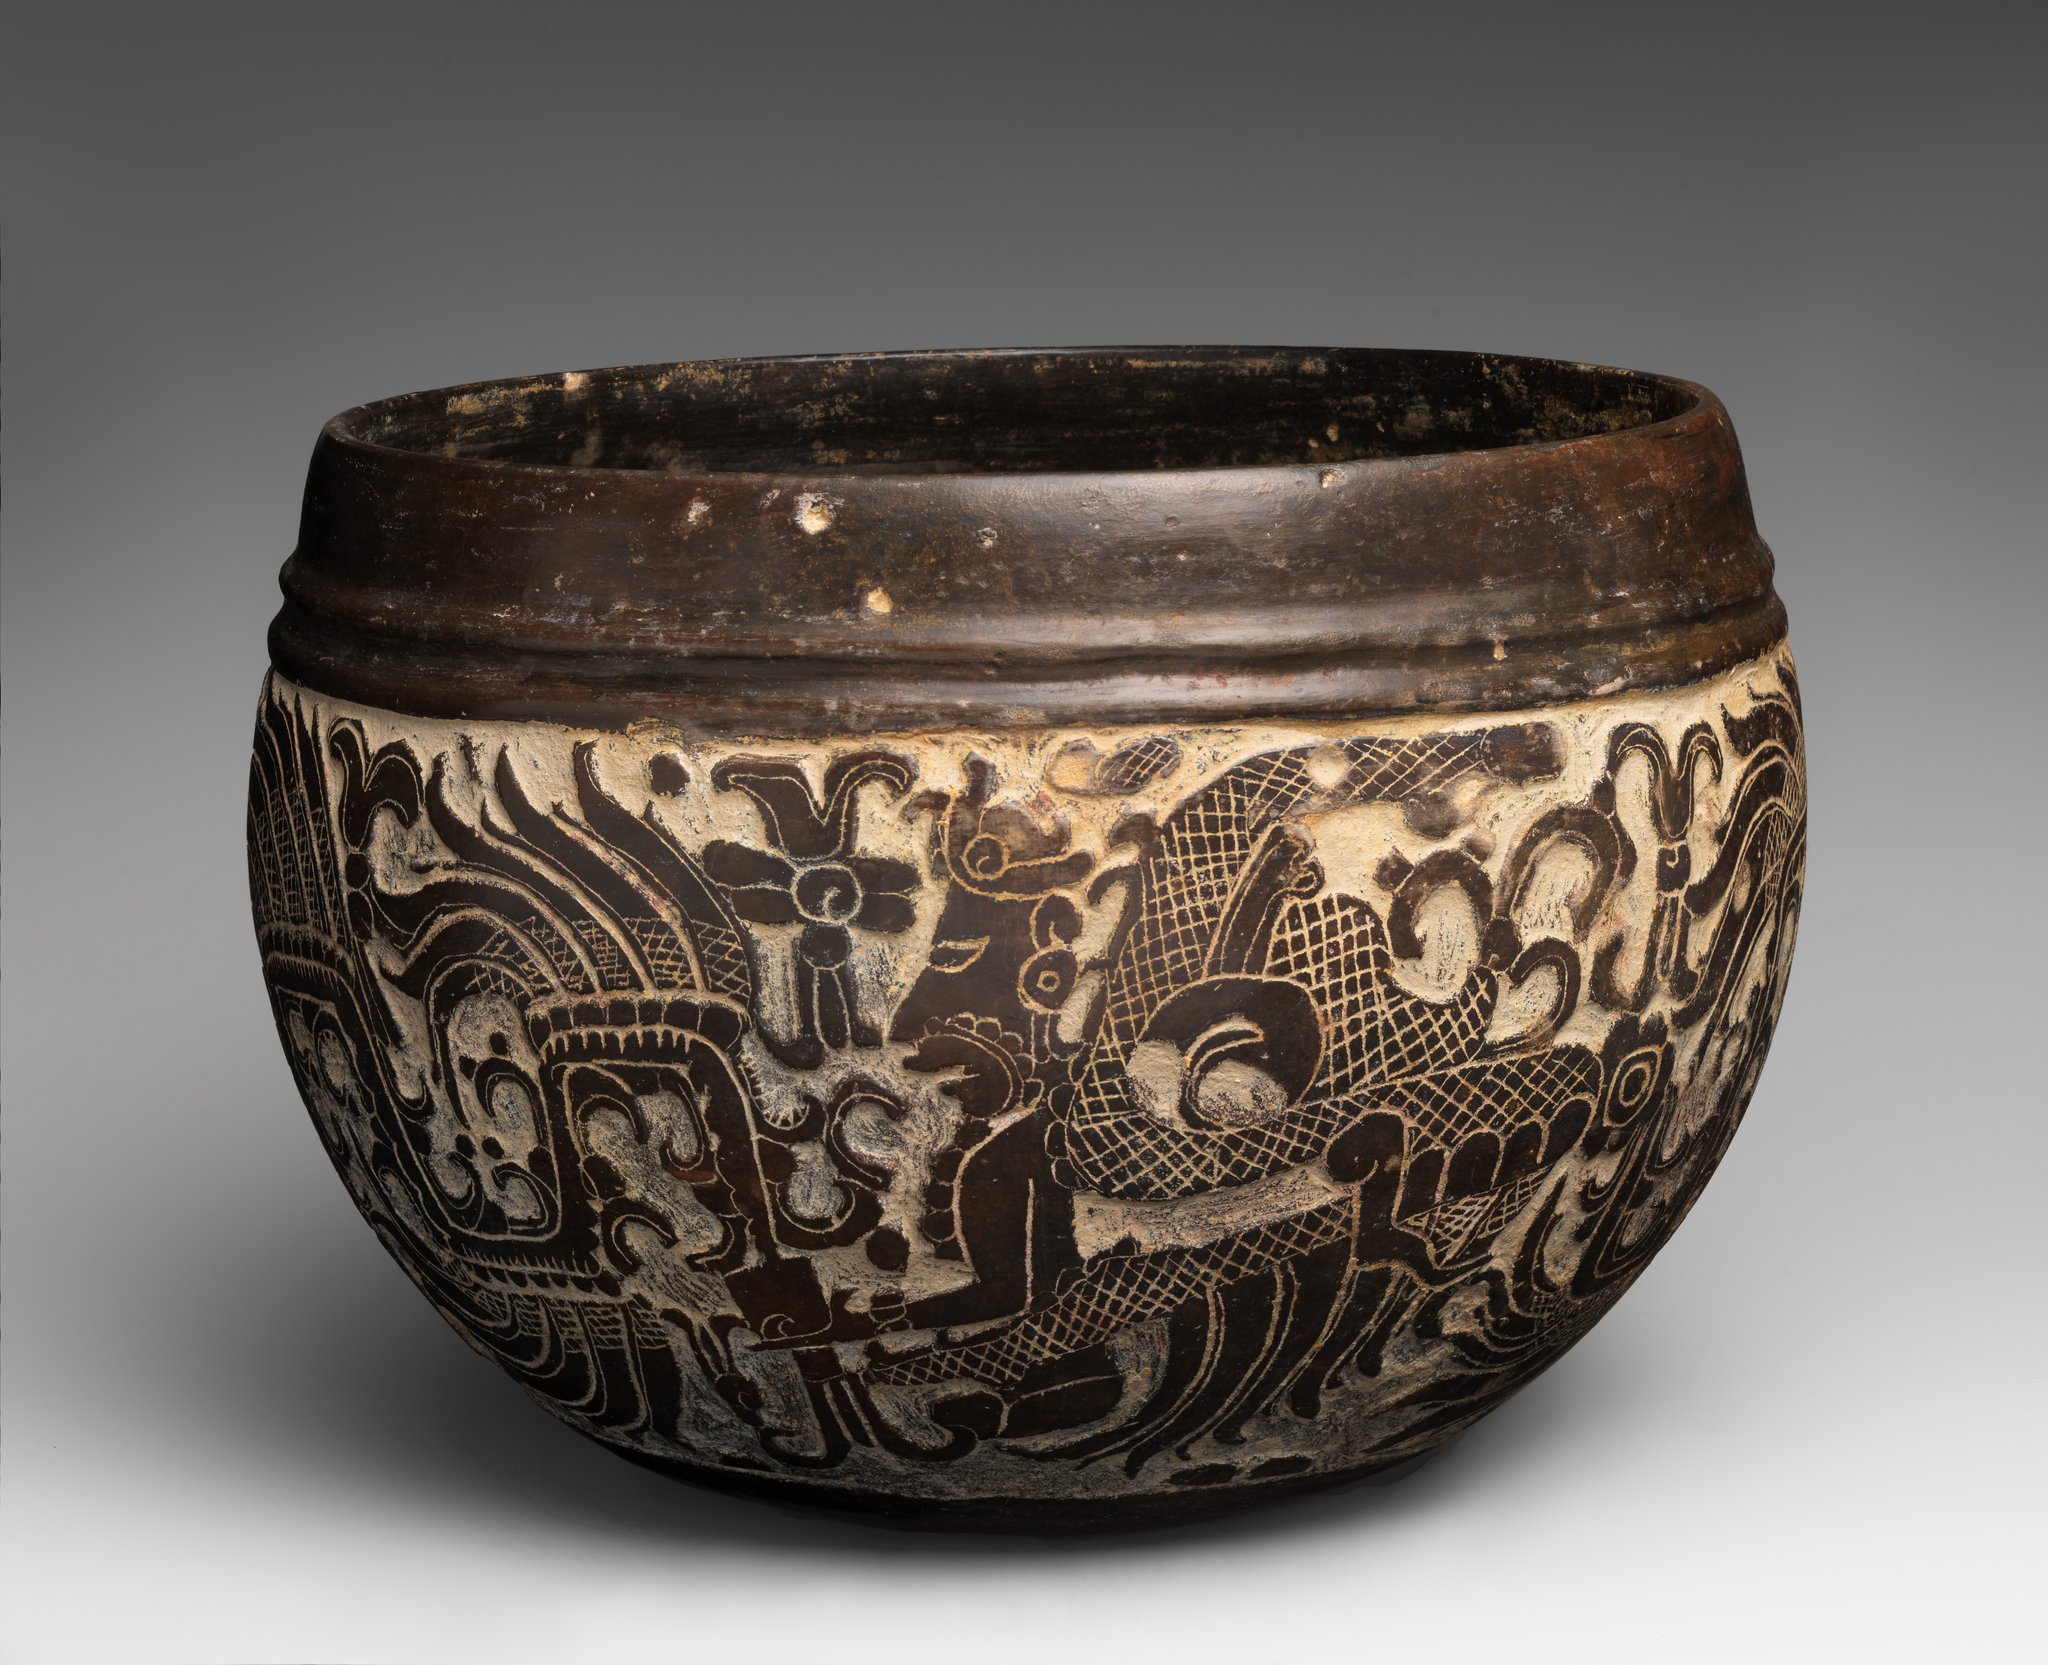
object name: bowl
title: Carved bowl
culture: maya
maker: maya artist(s)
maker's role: artist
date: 500-600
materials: ceramic, pigment, plaster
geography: guatemala or mexico